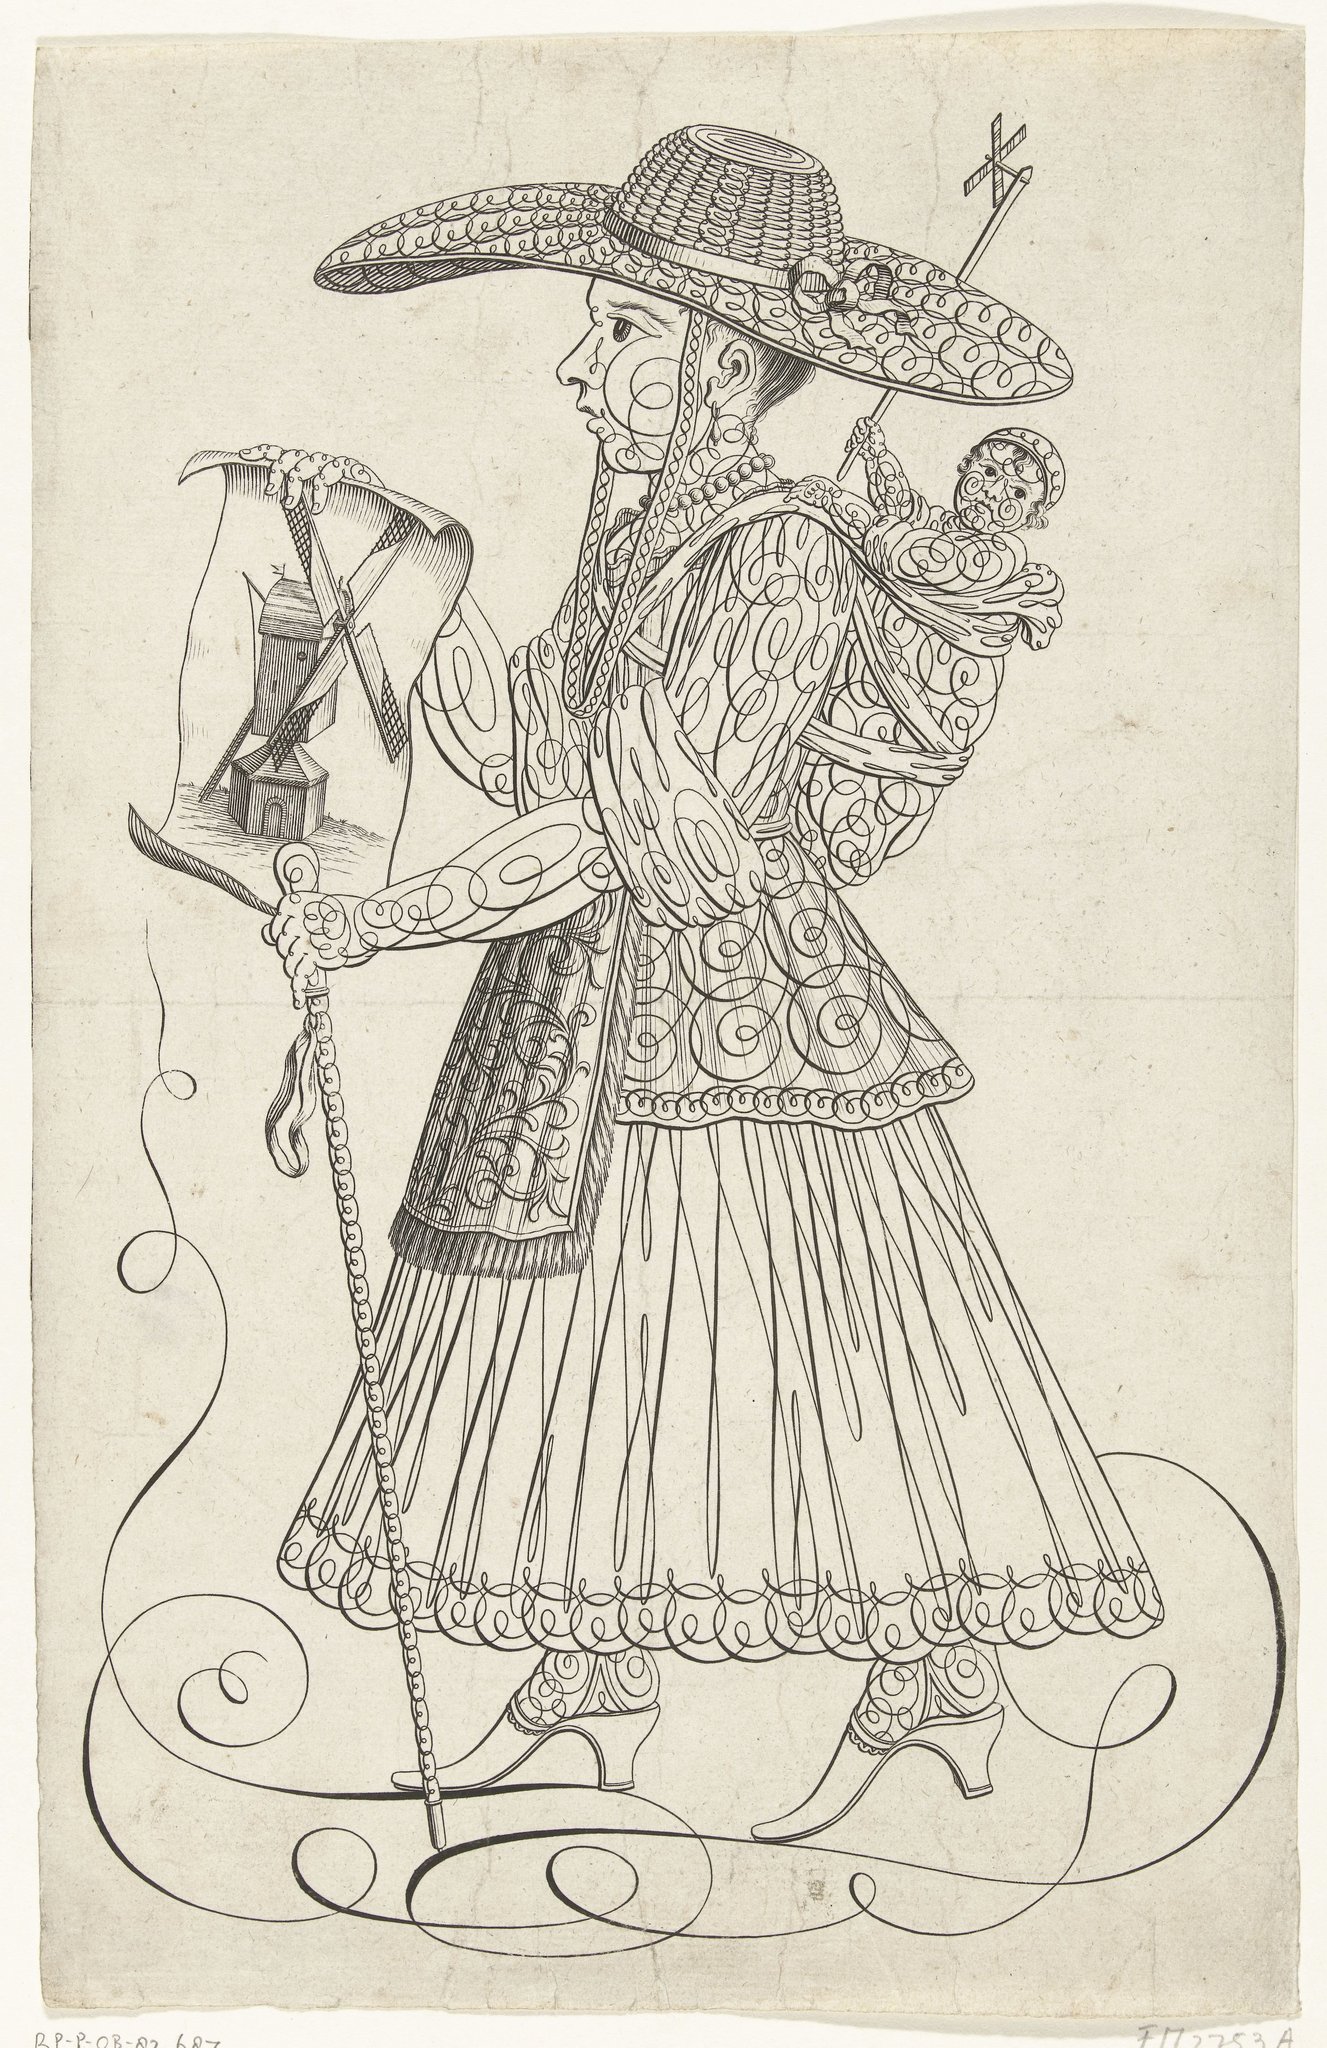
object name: print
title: Kalligrafie van vrouw met kind en windmolens, ca. 1720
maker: Anonymous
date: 1720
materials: paper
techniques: engraving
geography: northern netherlands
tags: london, calligraphy, infant, baby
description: Kalligrafie van vrouw met een papier met een afbeelding van een windmolen en met een kind op de rug met een speelgoed molentje in de hand. Spotprent op de windhandel in 1720. Door Muller beschreven als een spotprent op het molenaarskind, ondergeschoven als Jacobus Frans Eduard, de prins van Wales, ca. 1688-1689. Pendant van de Vermakelyken Actionist. Behoort dus tot de groep van bijprenten toegevoegd aan de serie Tafereel der Dwaasheid met spotprenten op de Windhandel of Actiehandel van 1720.